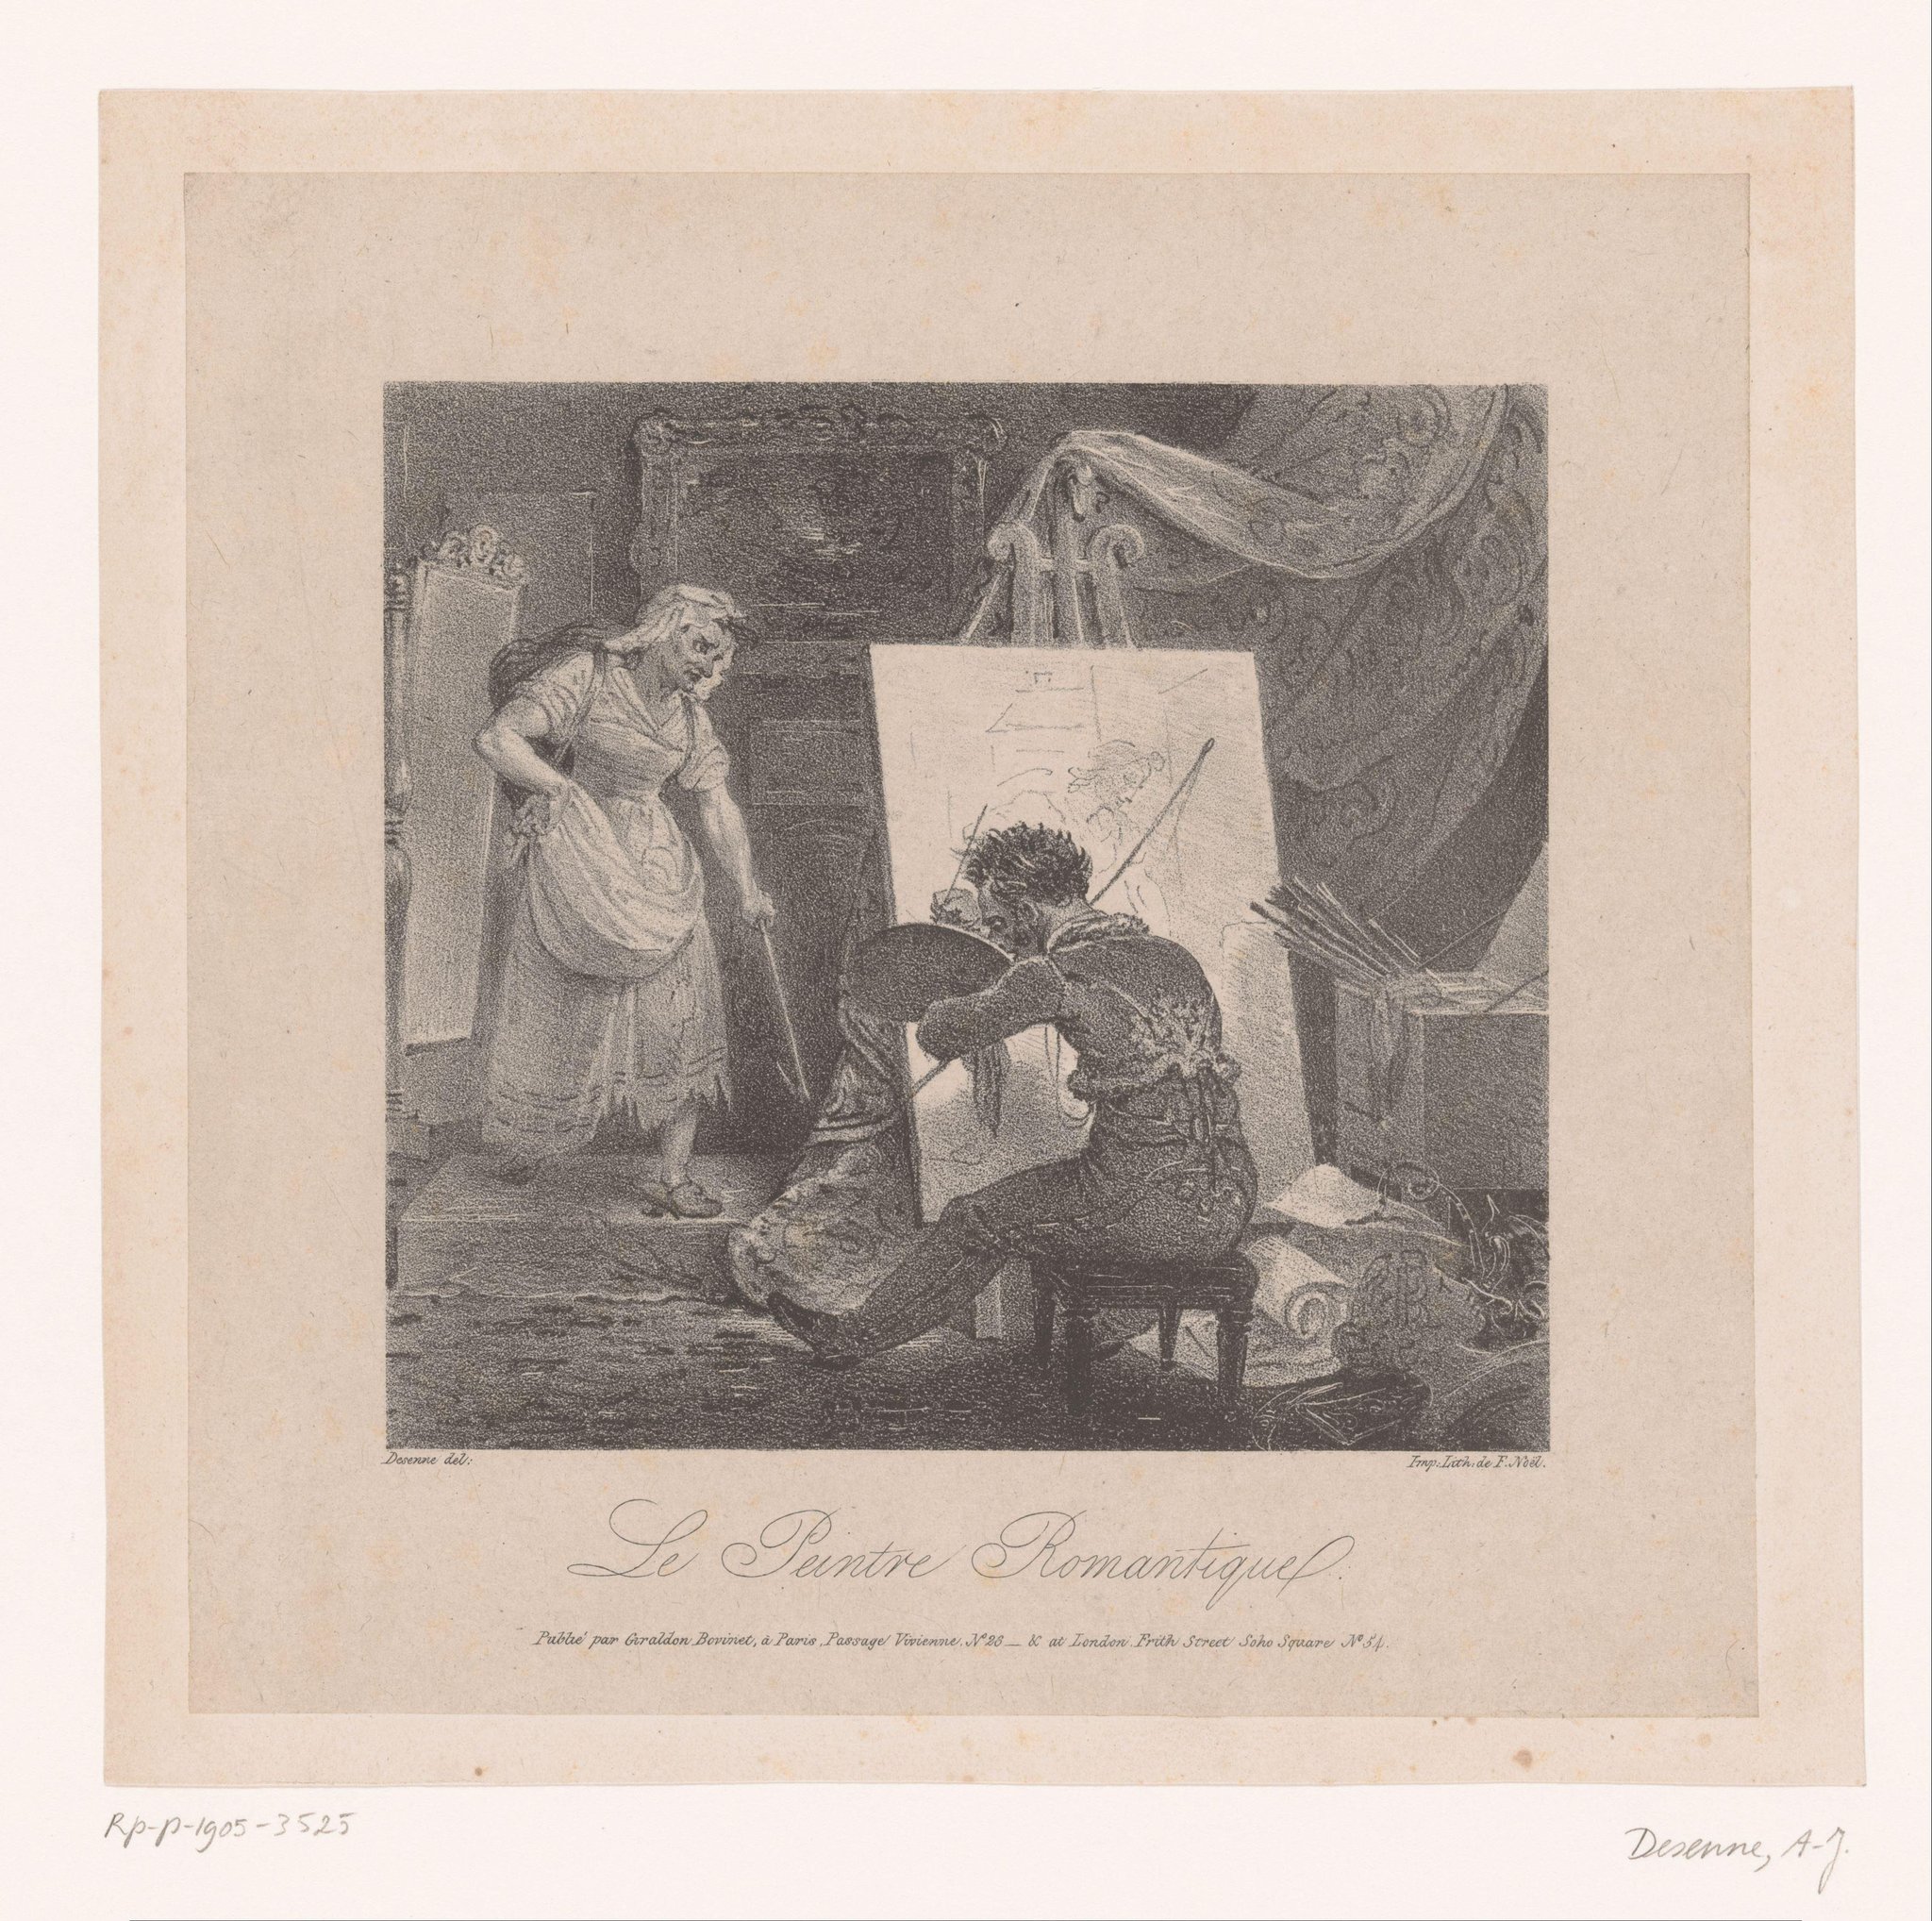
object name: print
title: Kunstenaar schildert zijn model in het atelier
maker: alexandre-joseph desenne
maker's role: painter, print maker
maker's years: 1785-1827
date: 1826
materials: paper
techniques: lithograph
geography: paris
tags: artist's model, sitter, painter at work, in his studio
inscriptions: collector's mark: Lugt 2228a